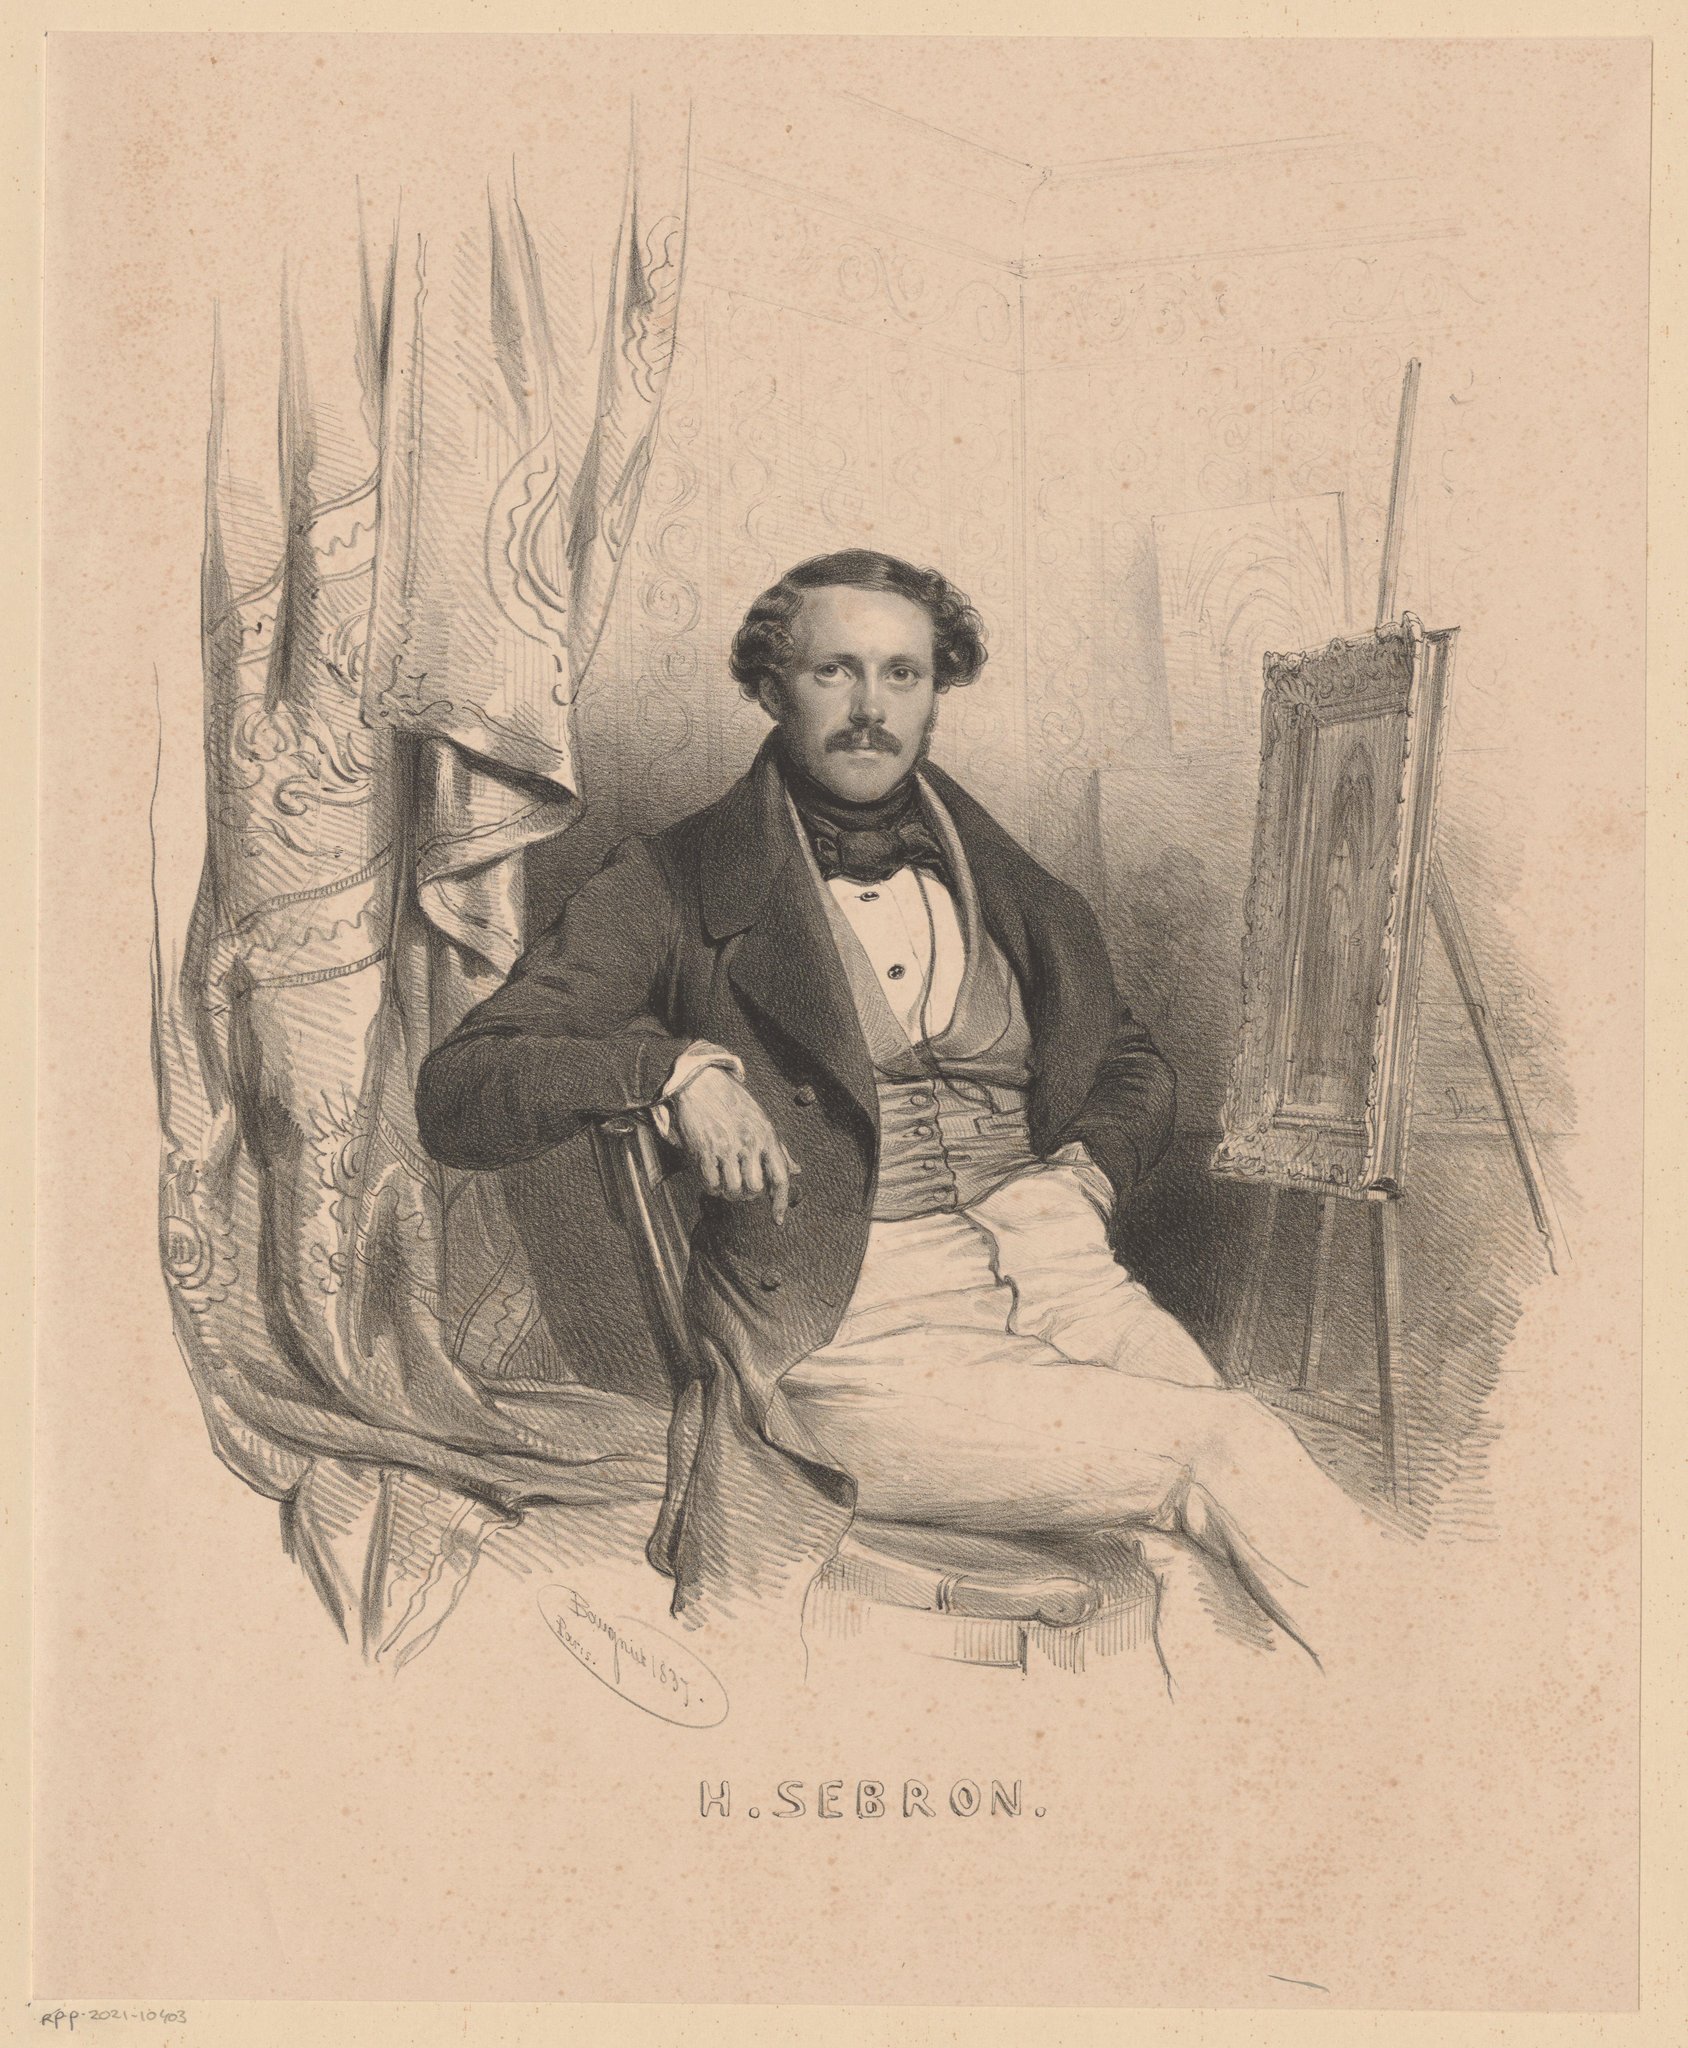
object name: print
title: H. Sebron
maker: charles baugniet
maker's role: print maker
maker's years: 1814-1886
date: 1837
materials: paper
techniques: lithograph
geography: paris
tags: paris, draughtsman, hippolyte victor valentin sebron, adult man, historical persons, easel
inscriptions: date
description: Prent mogelijk uit: Baugniet, Charles. Les artistes contemporains: portraits lithographiés d'après nature, accompagnés de notices sur la vie et les ouvrages de chacun d'eux. Brussel: De Wasme-Pletinckx, [1836-1840].